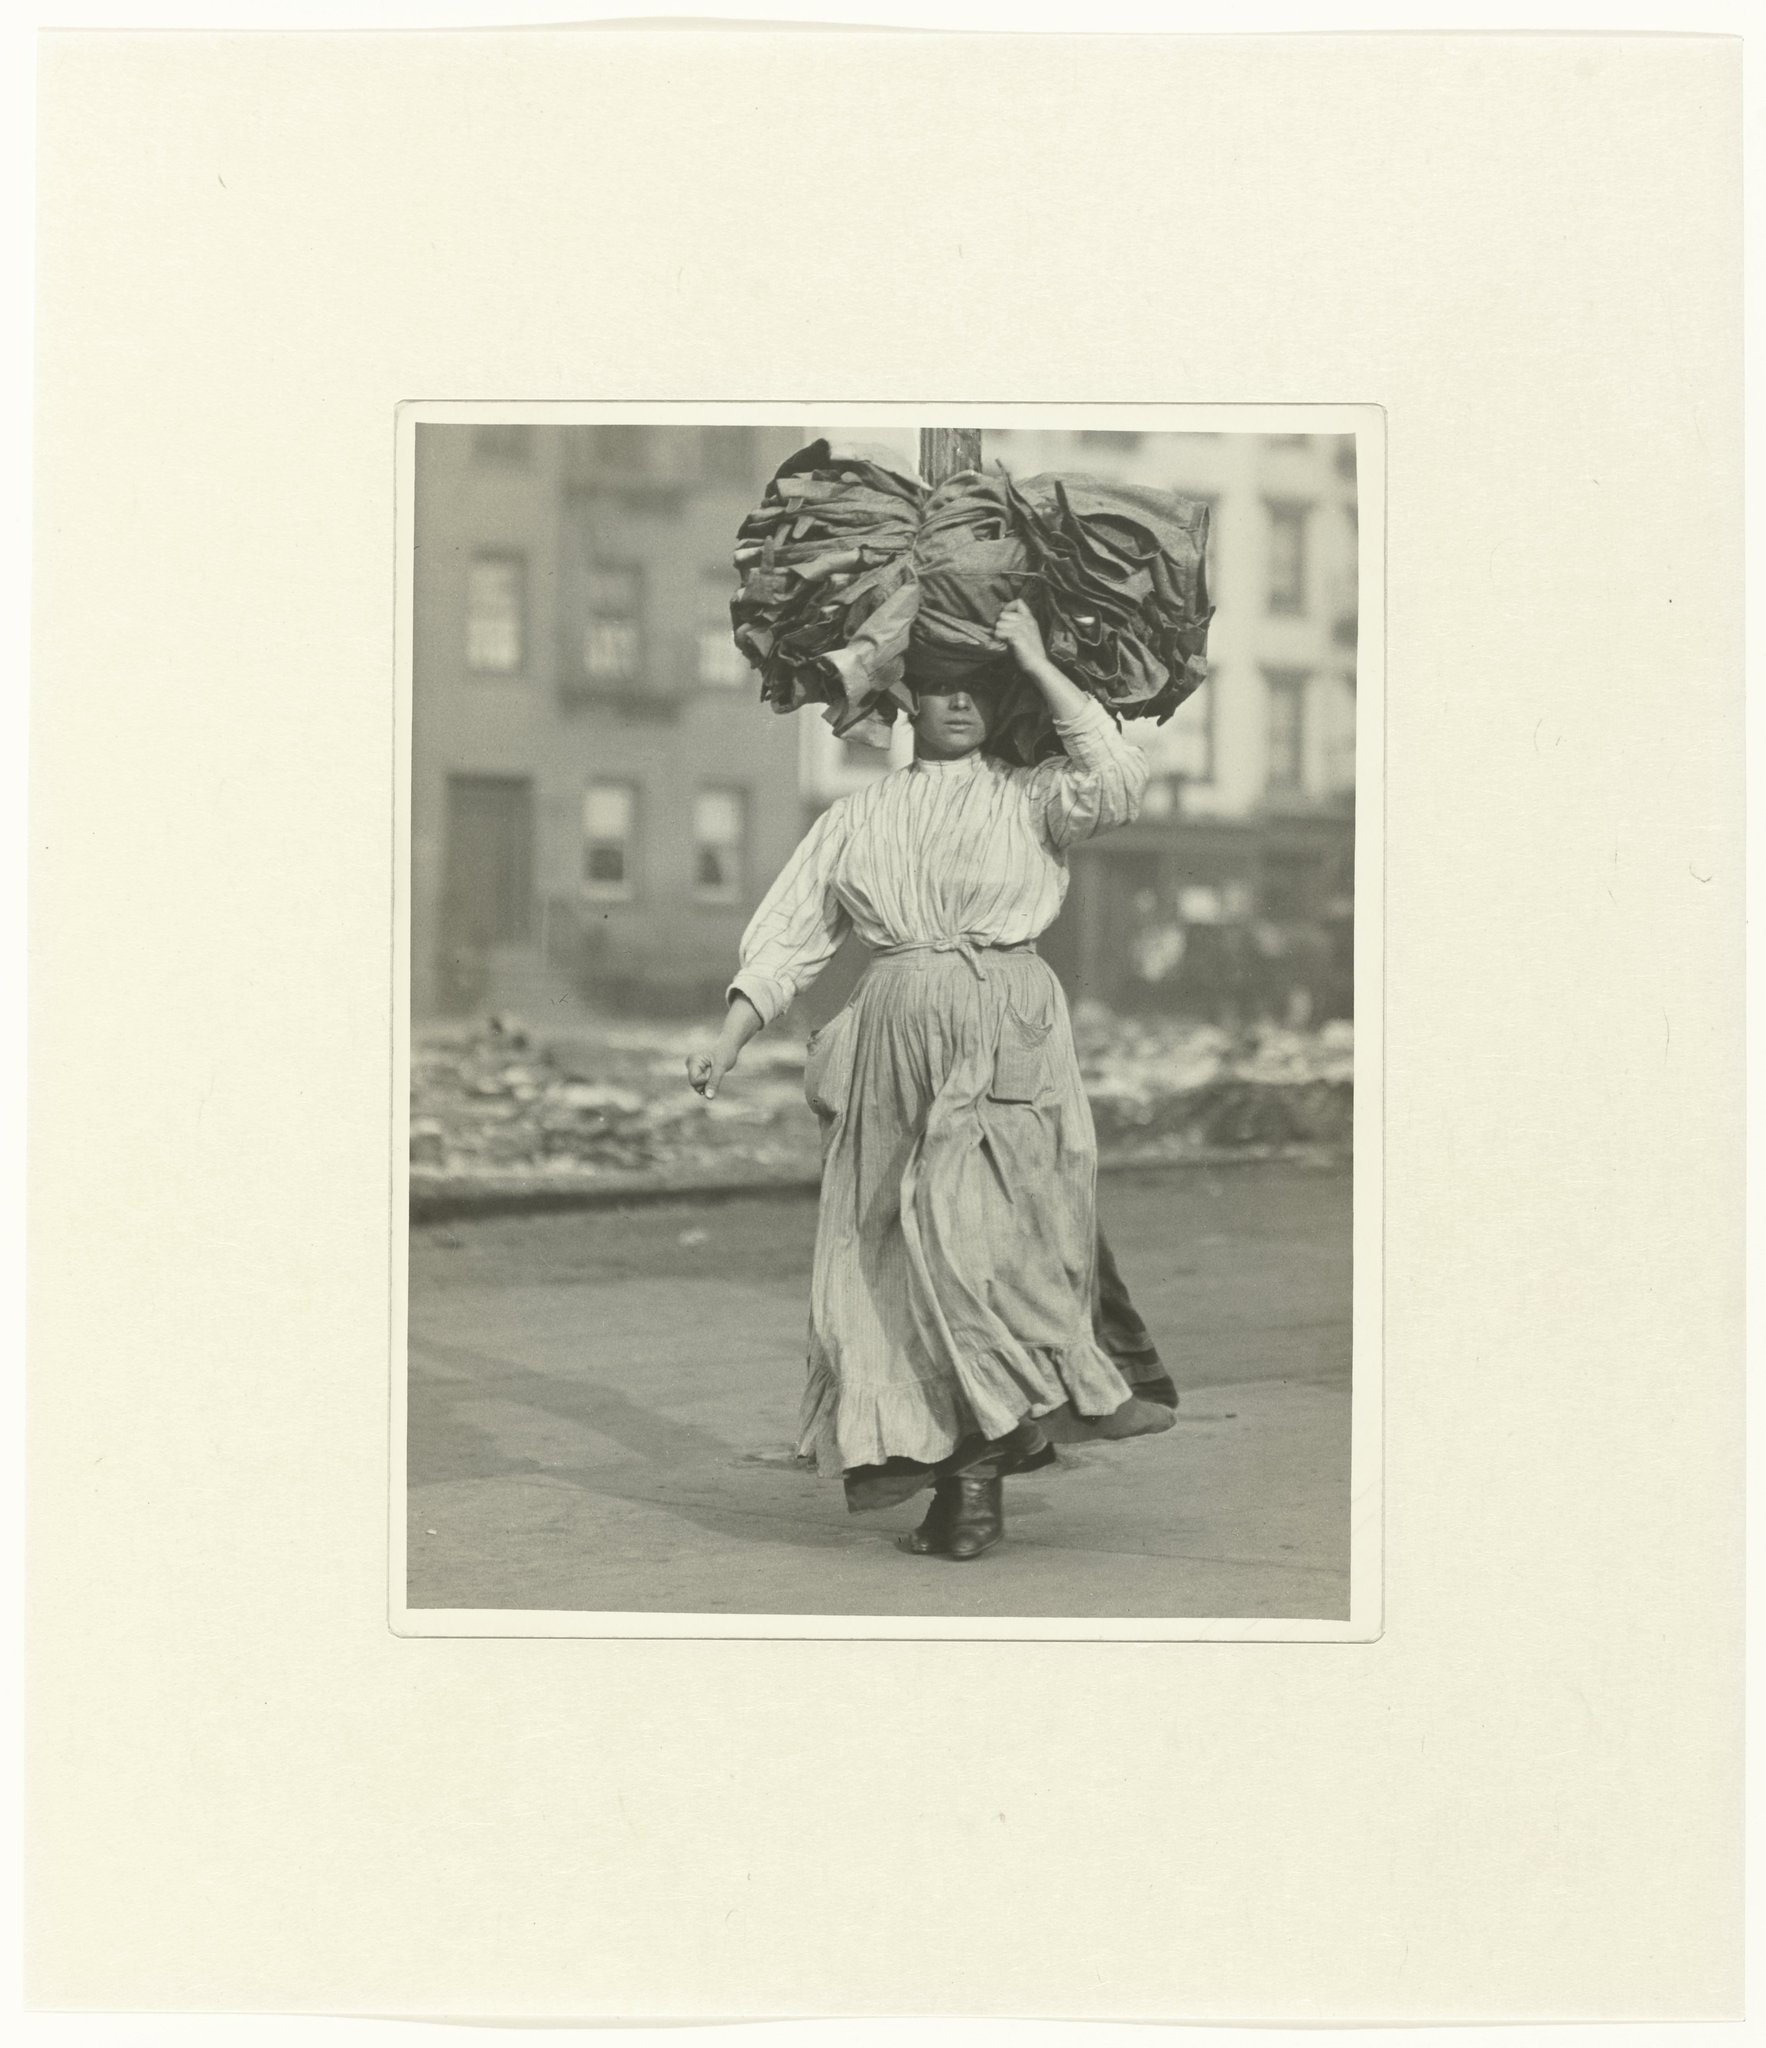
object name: photograph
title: Italian Immigrant, East Side, New York City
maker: lewis wickes hine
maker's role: fotograaf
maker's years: 1874-1940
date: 1910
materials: paper, cardboard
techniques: gelatin silver print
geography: new york city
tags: adult woman, immigration, new york (city)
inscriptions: inscription: ‘PO791LH/ 084.022.3.03/ 282 [?]’, inscription: ‘First work in America/ Italian immigrant carries garment/ to tenenent home for the family/ P-856/ Coronet left/ 4016’, inscription: ‘LEWIS W. HINE/ INTERPRETIVE PHOTOGRAPHY/ HASTINGS-ON-HUDSON, NEW YORK’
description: Hine portrayed the European immigrants who came to America at the beginning of the 20th century. Life was hard in a big city where hundreds of thousands of people were looking for ways to make a living. Italian women were employed in ‘sweatshops’, sewing workshops, where they were grievously exploited. Even children, like this barefoot newspaper boy, were sent out to earn money.